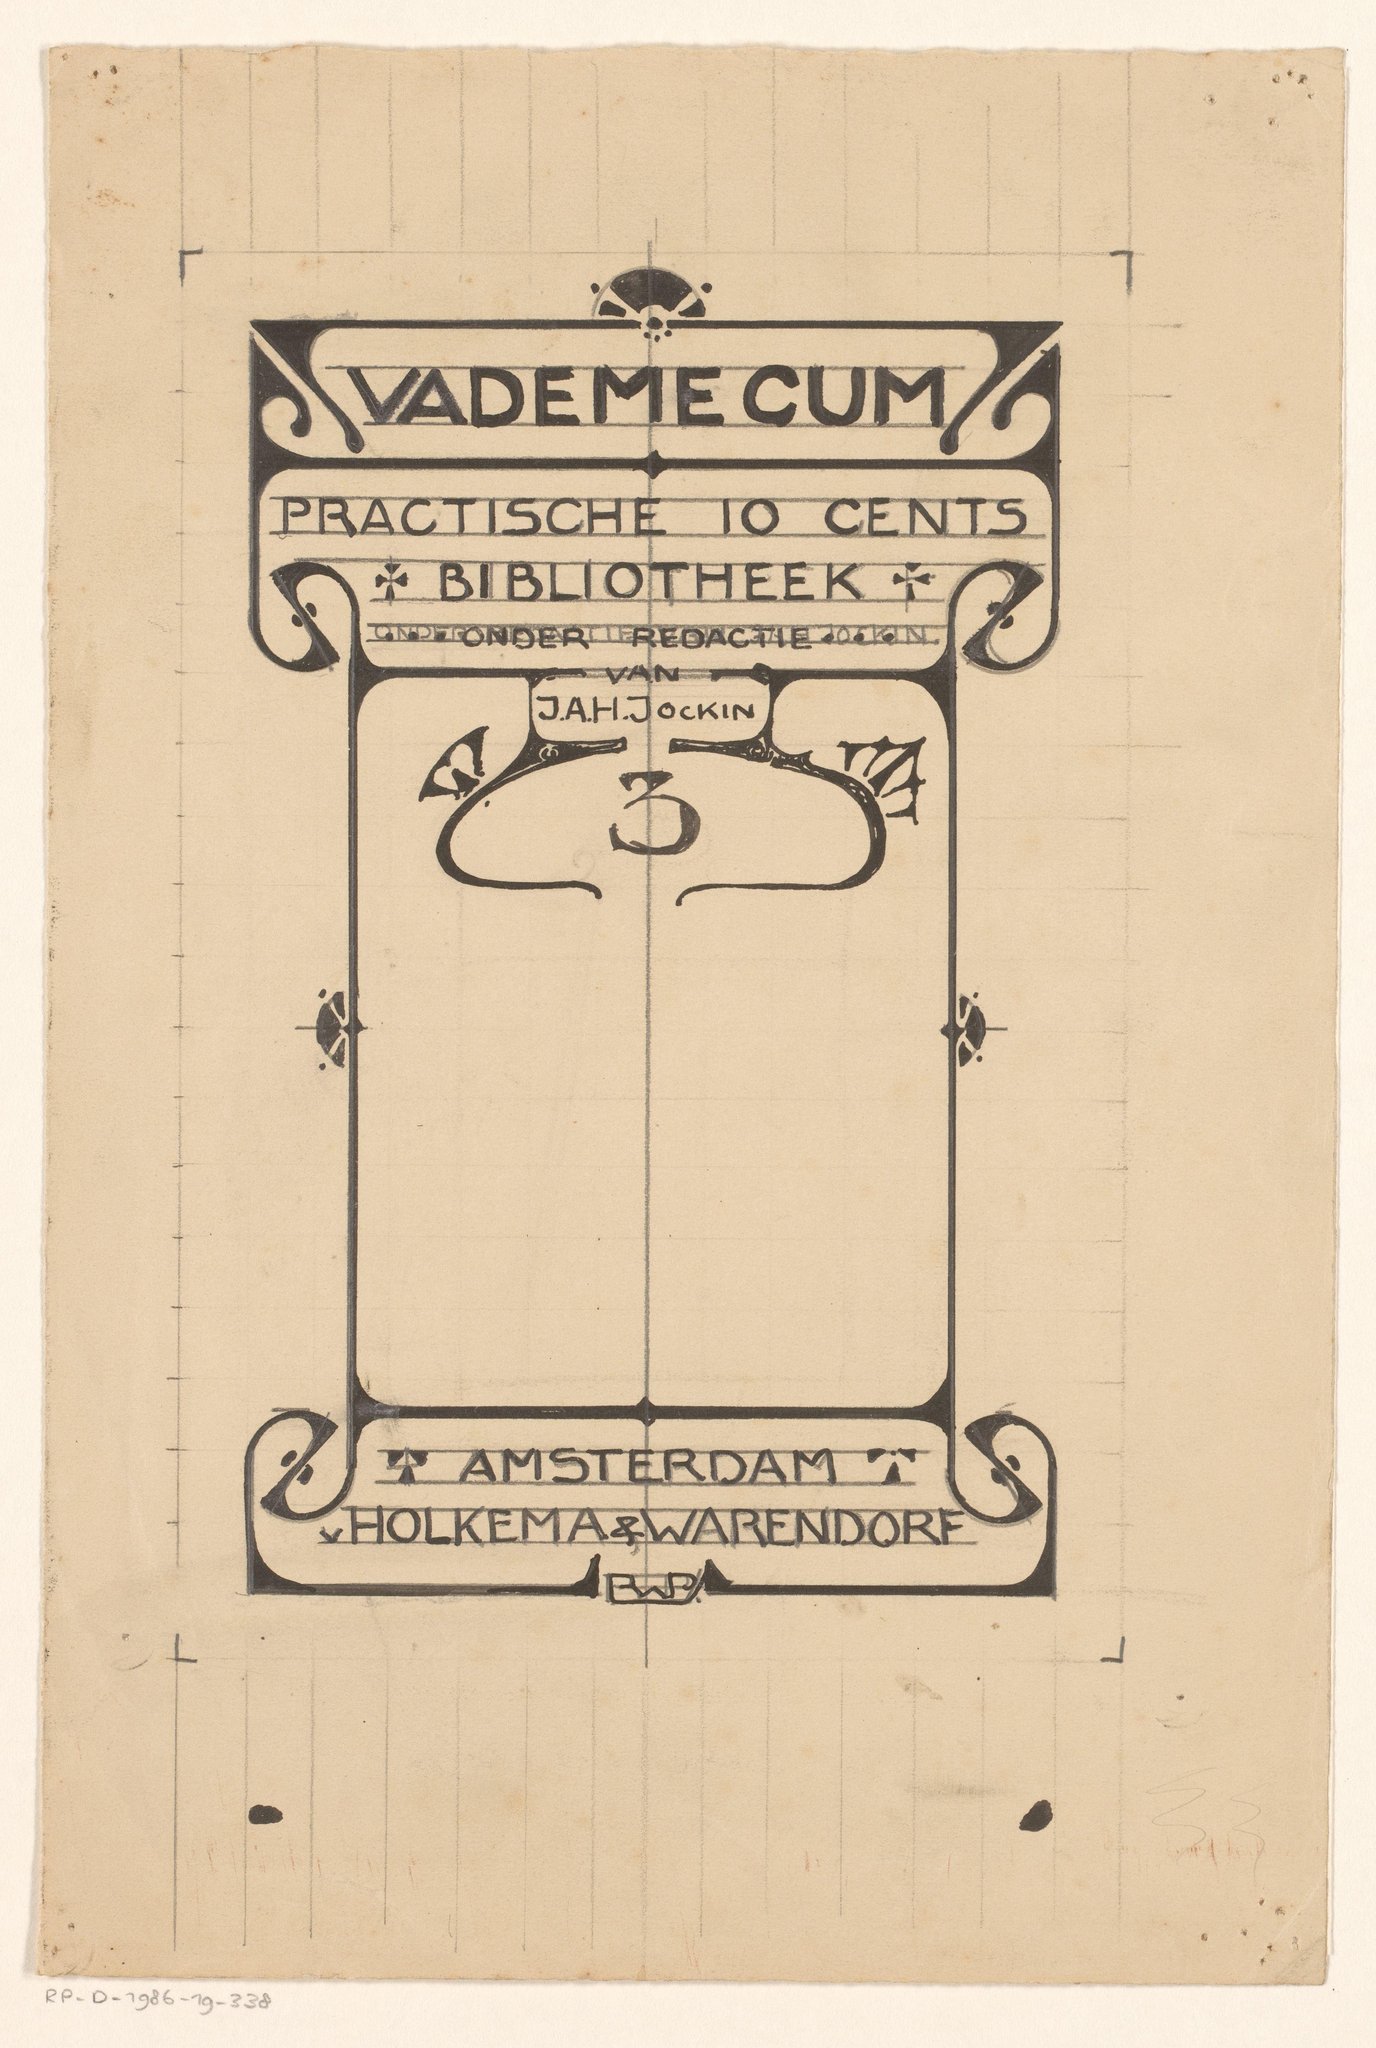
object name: design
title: Omslagontwerp voor: Vademecum. Praktische 10 cents bibliotheek, 1903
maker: reinier willem petrus de vries (1874-1953)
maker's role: draughtsman, print maker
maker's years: 1874-1953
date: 1903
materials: ink, paper, pencil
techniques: brush, pen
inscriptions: collector's mark: ‘R:MVS.’